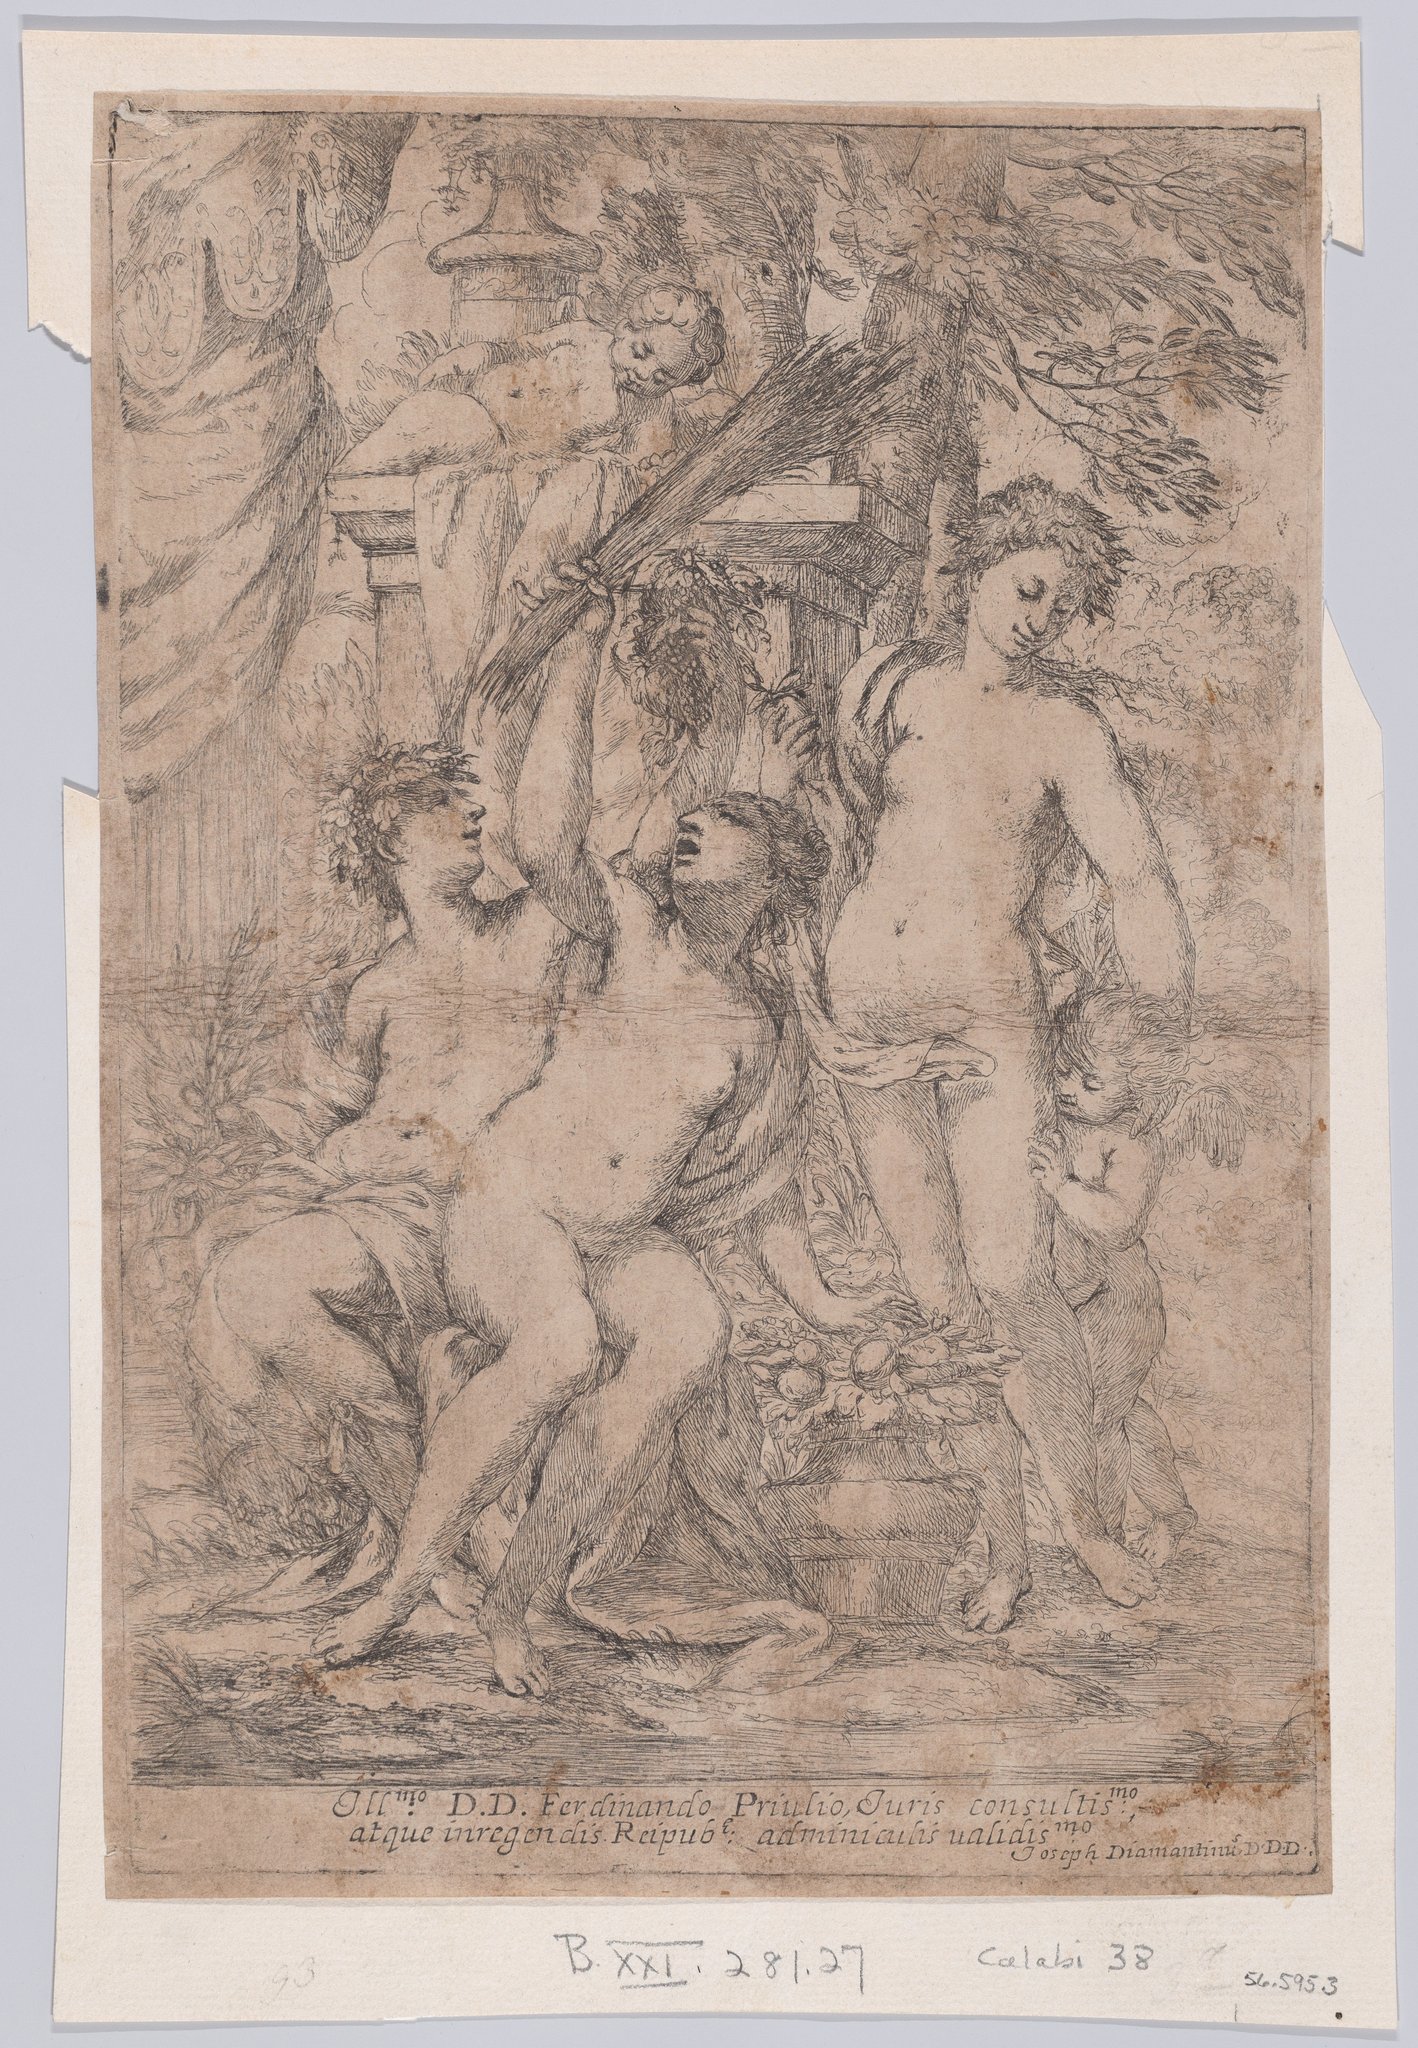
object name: print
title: Diana and Endymion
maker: giuseppe diamantini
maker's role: artist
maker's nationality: italian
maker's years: 1621-1705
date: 1650-1700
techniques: etching